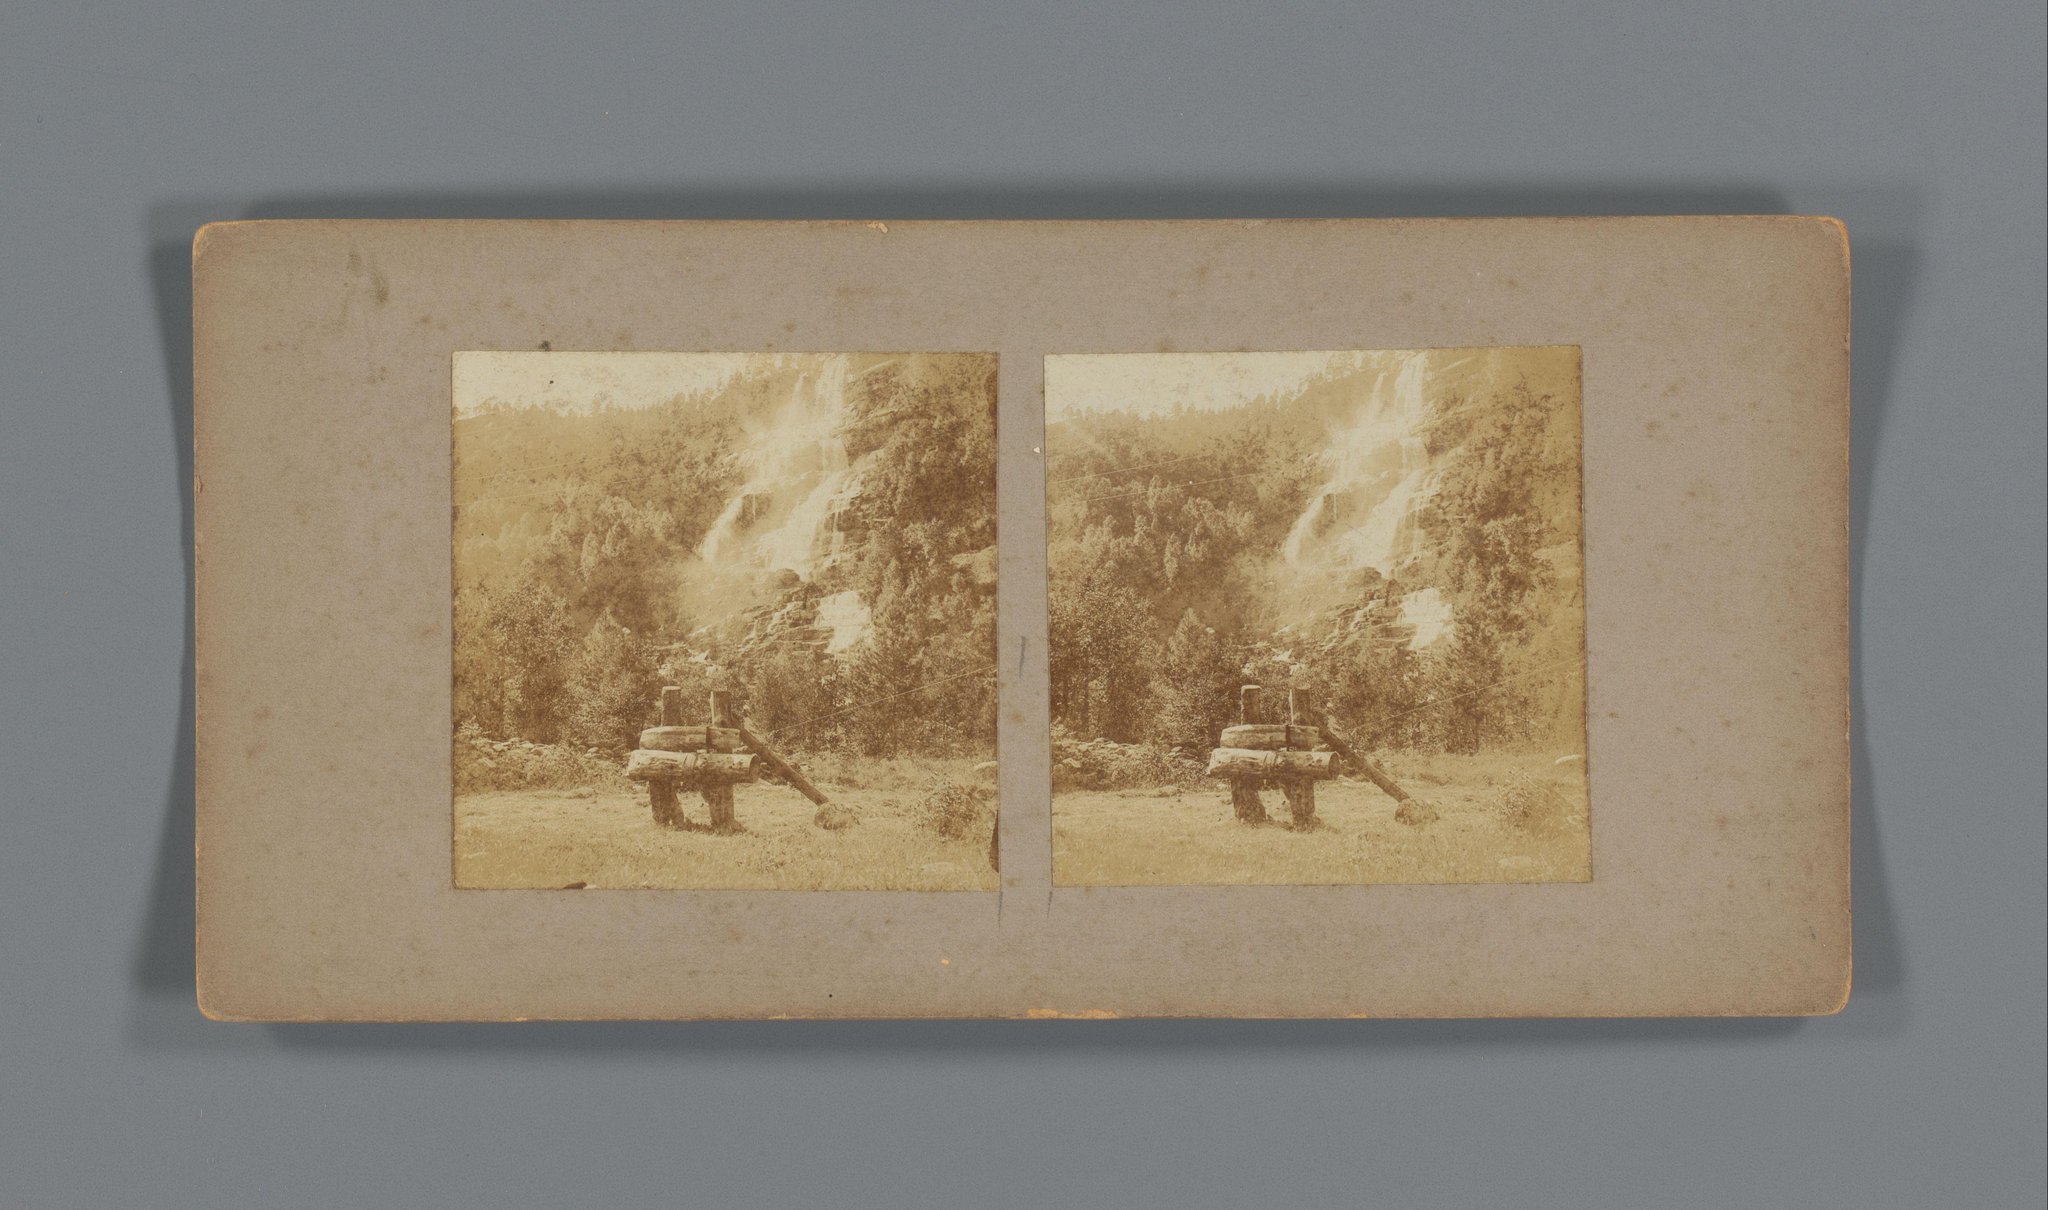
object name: stereograph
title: Tvende waterval bij Vossenvangen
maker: Anonymous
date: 1882-1890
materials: cardboard, photographic support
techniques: gelatin silver print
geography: voss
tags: waterfall